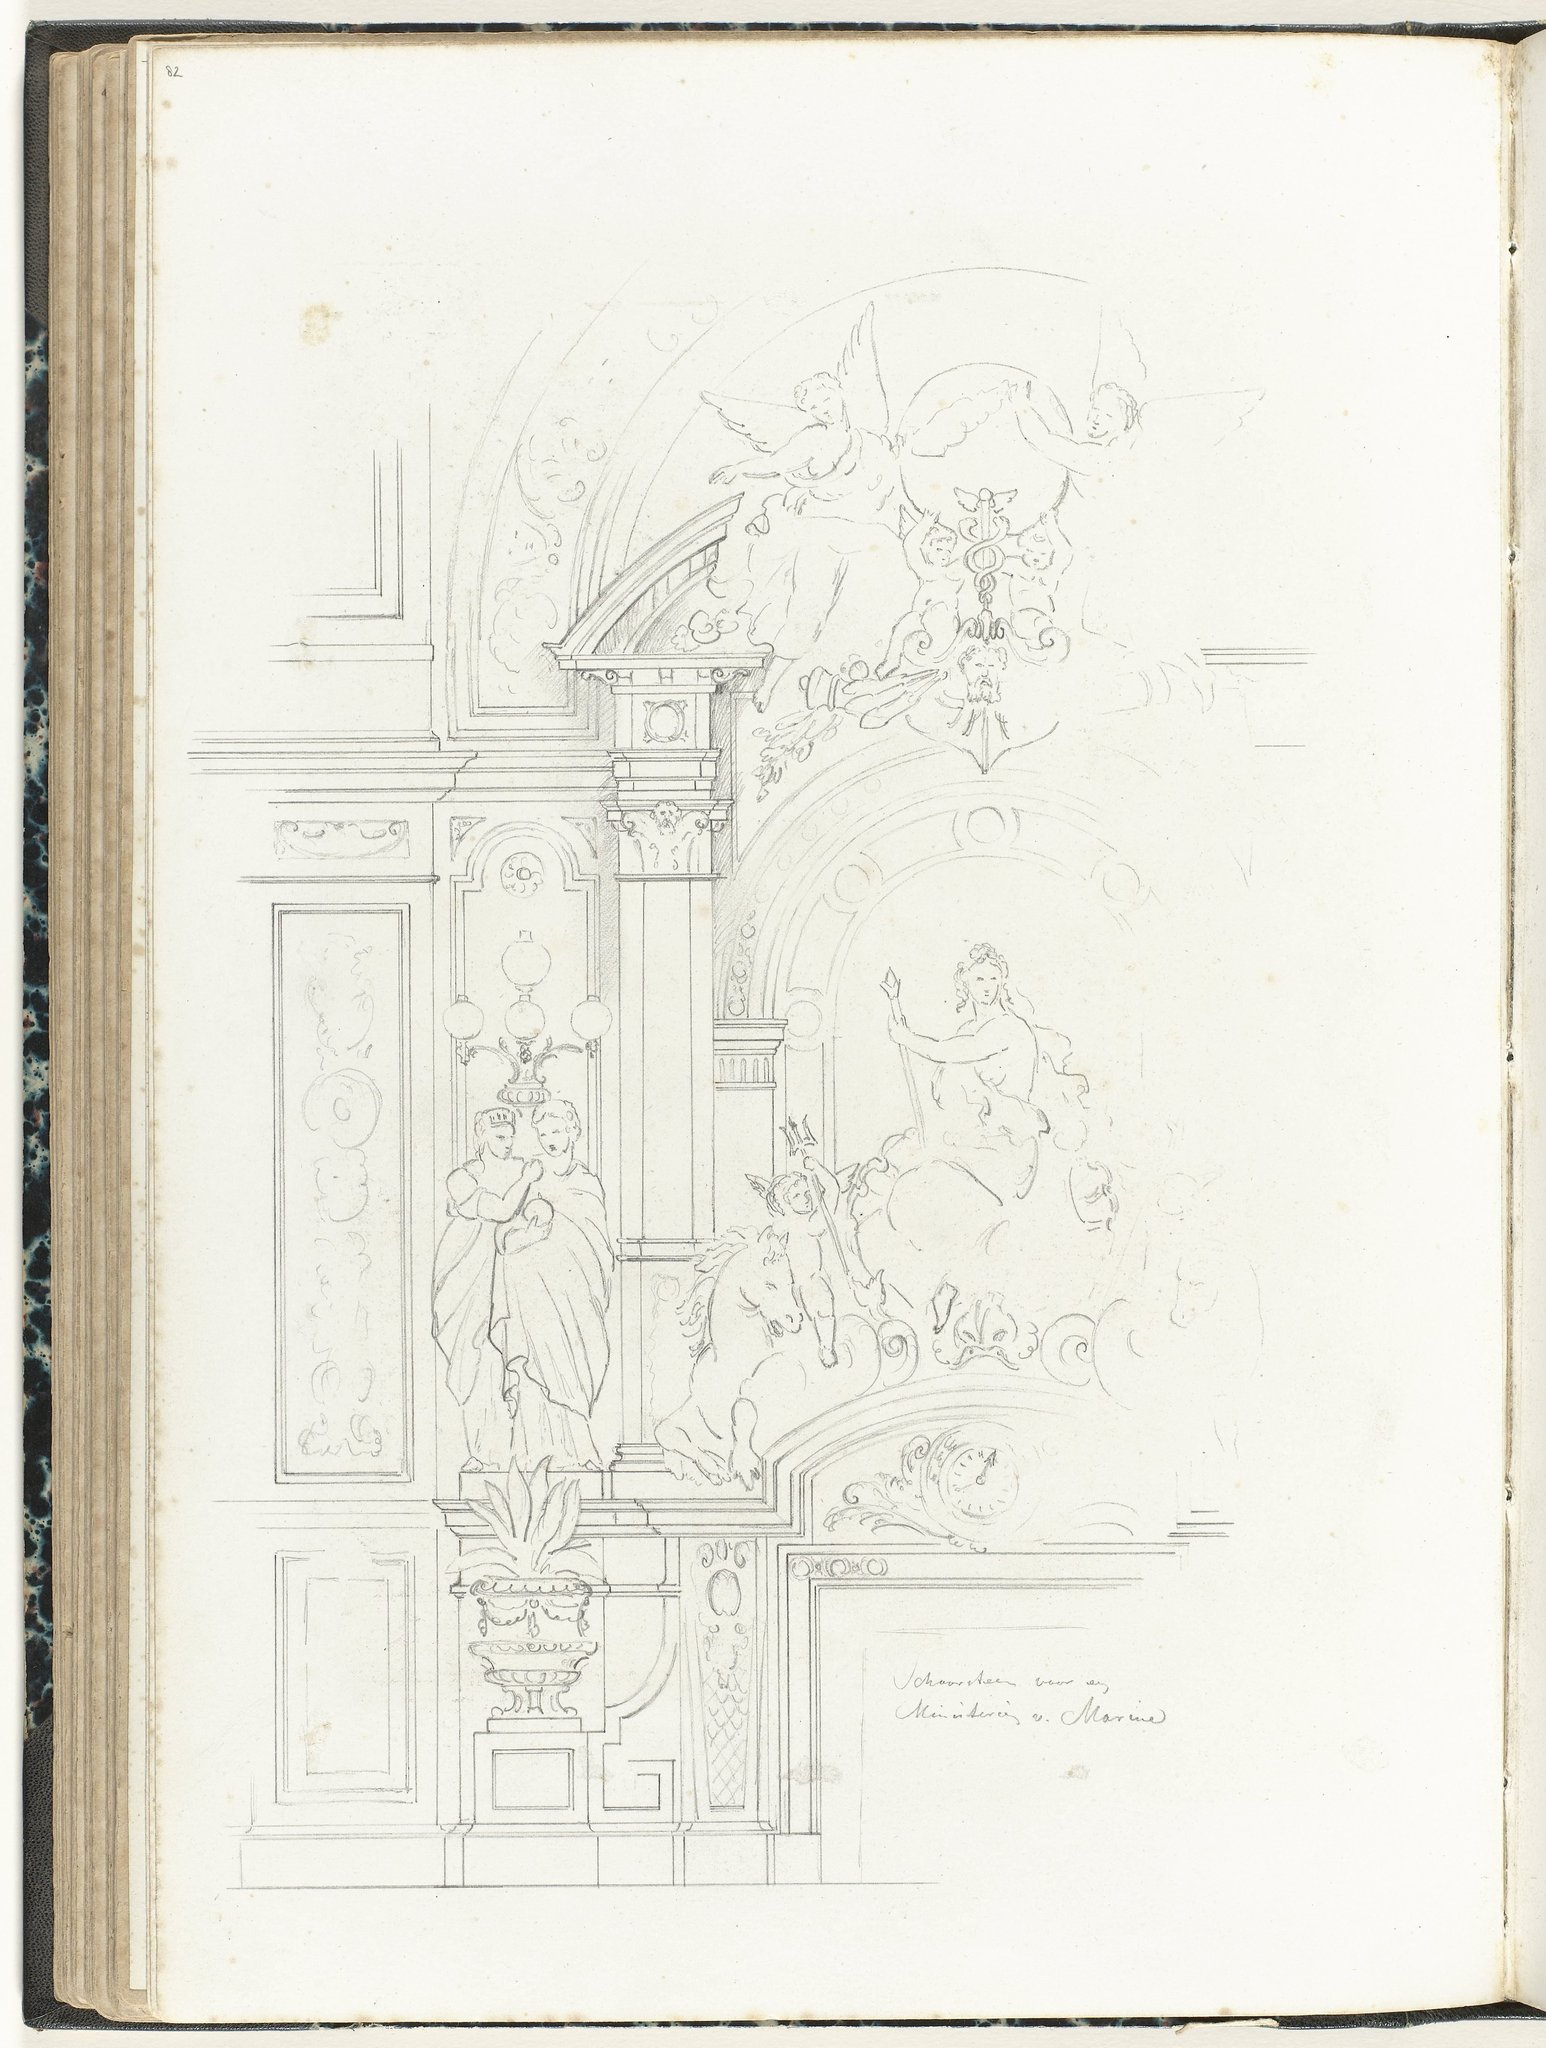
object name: drawing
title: Schouw voor Ministerie van Marine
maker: Anonymous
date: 1866-1900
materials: pencil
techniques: drawing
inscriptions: annotation: ‘Schoorsteen voor het Ministerie v. Marine (?)’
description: Schouw met bovenaan twee engelen en twee putti die een bol ondersteunen. In het midden zit een putto met een drietand op een zeepaard.